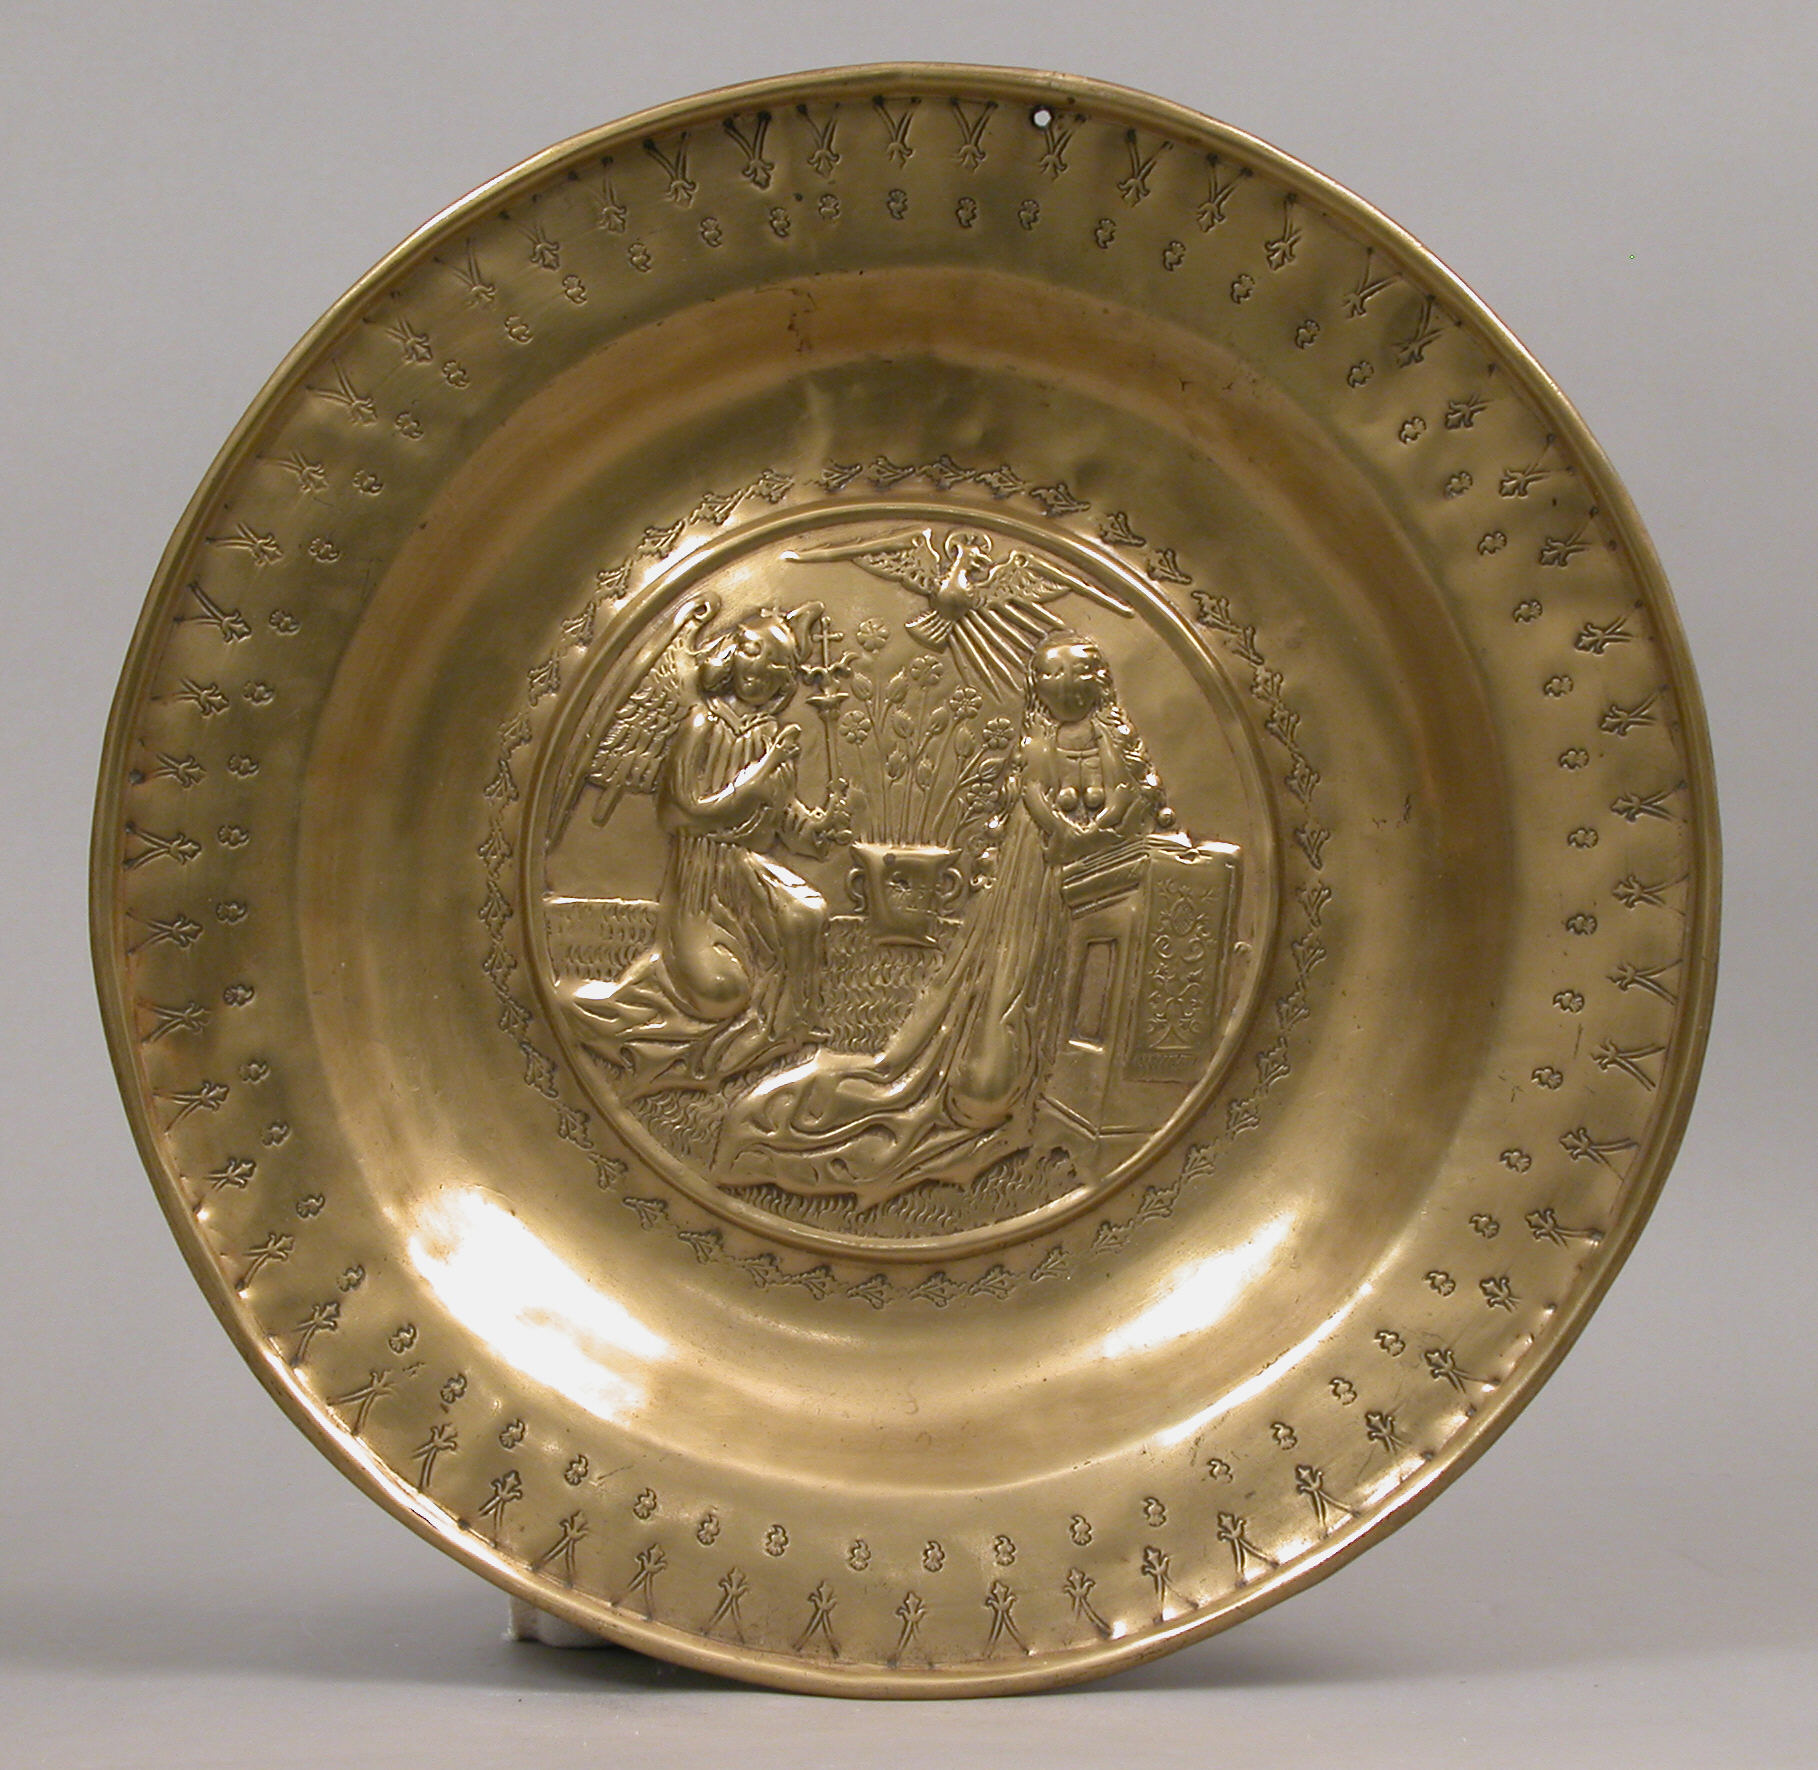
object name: dish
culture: german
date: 1501-1533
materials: brass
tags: birds,women,angels,cross